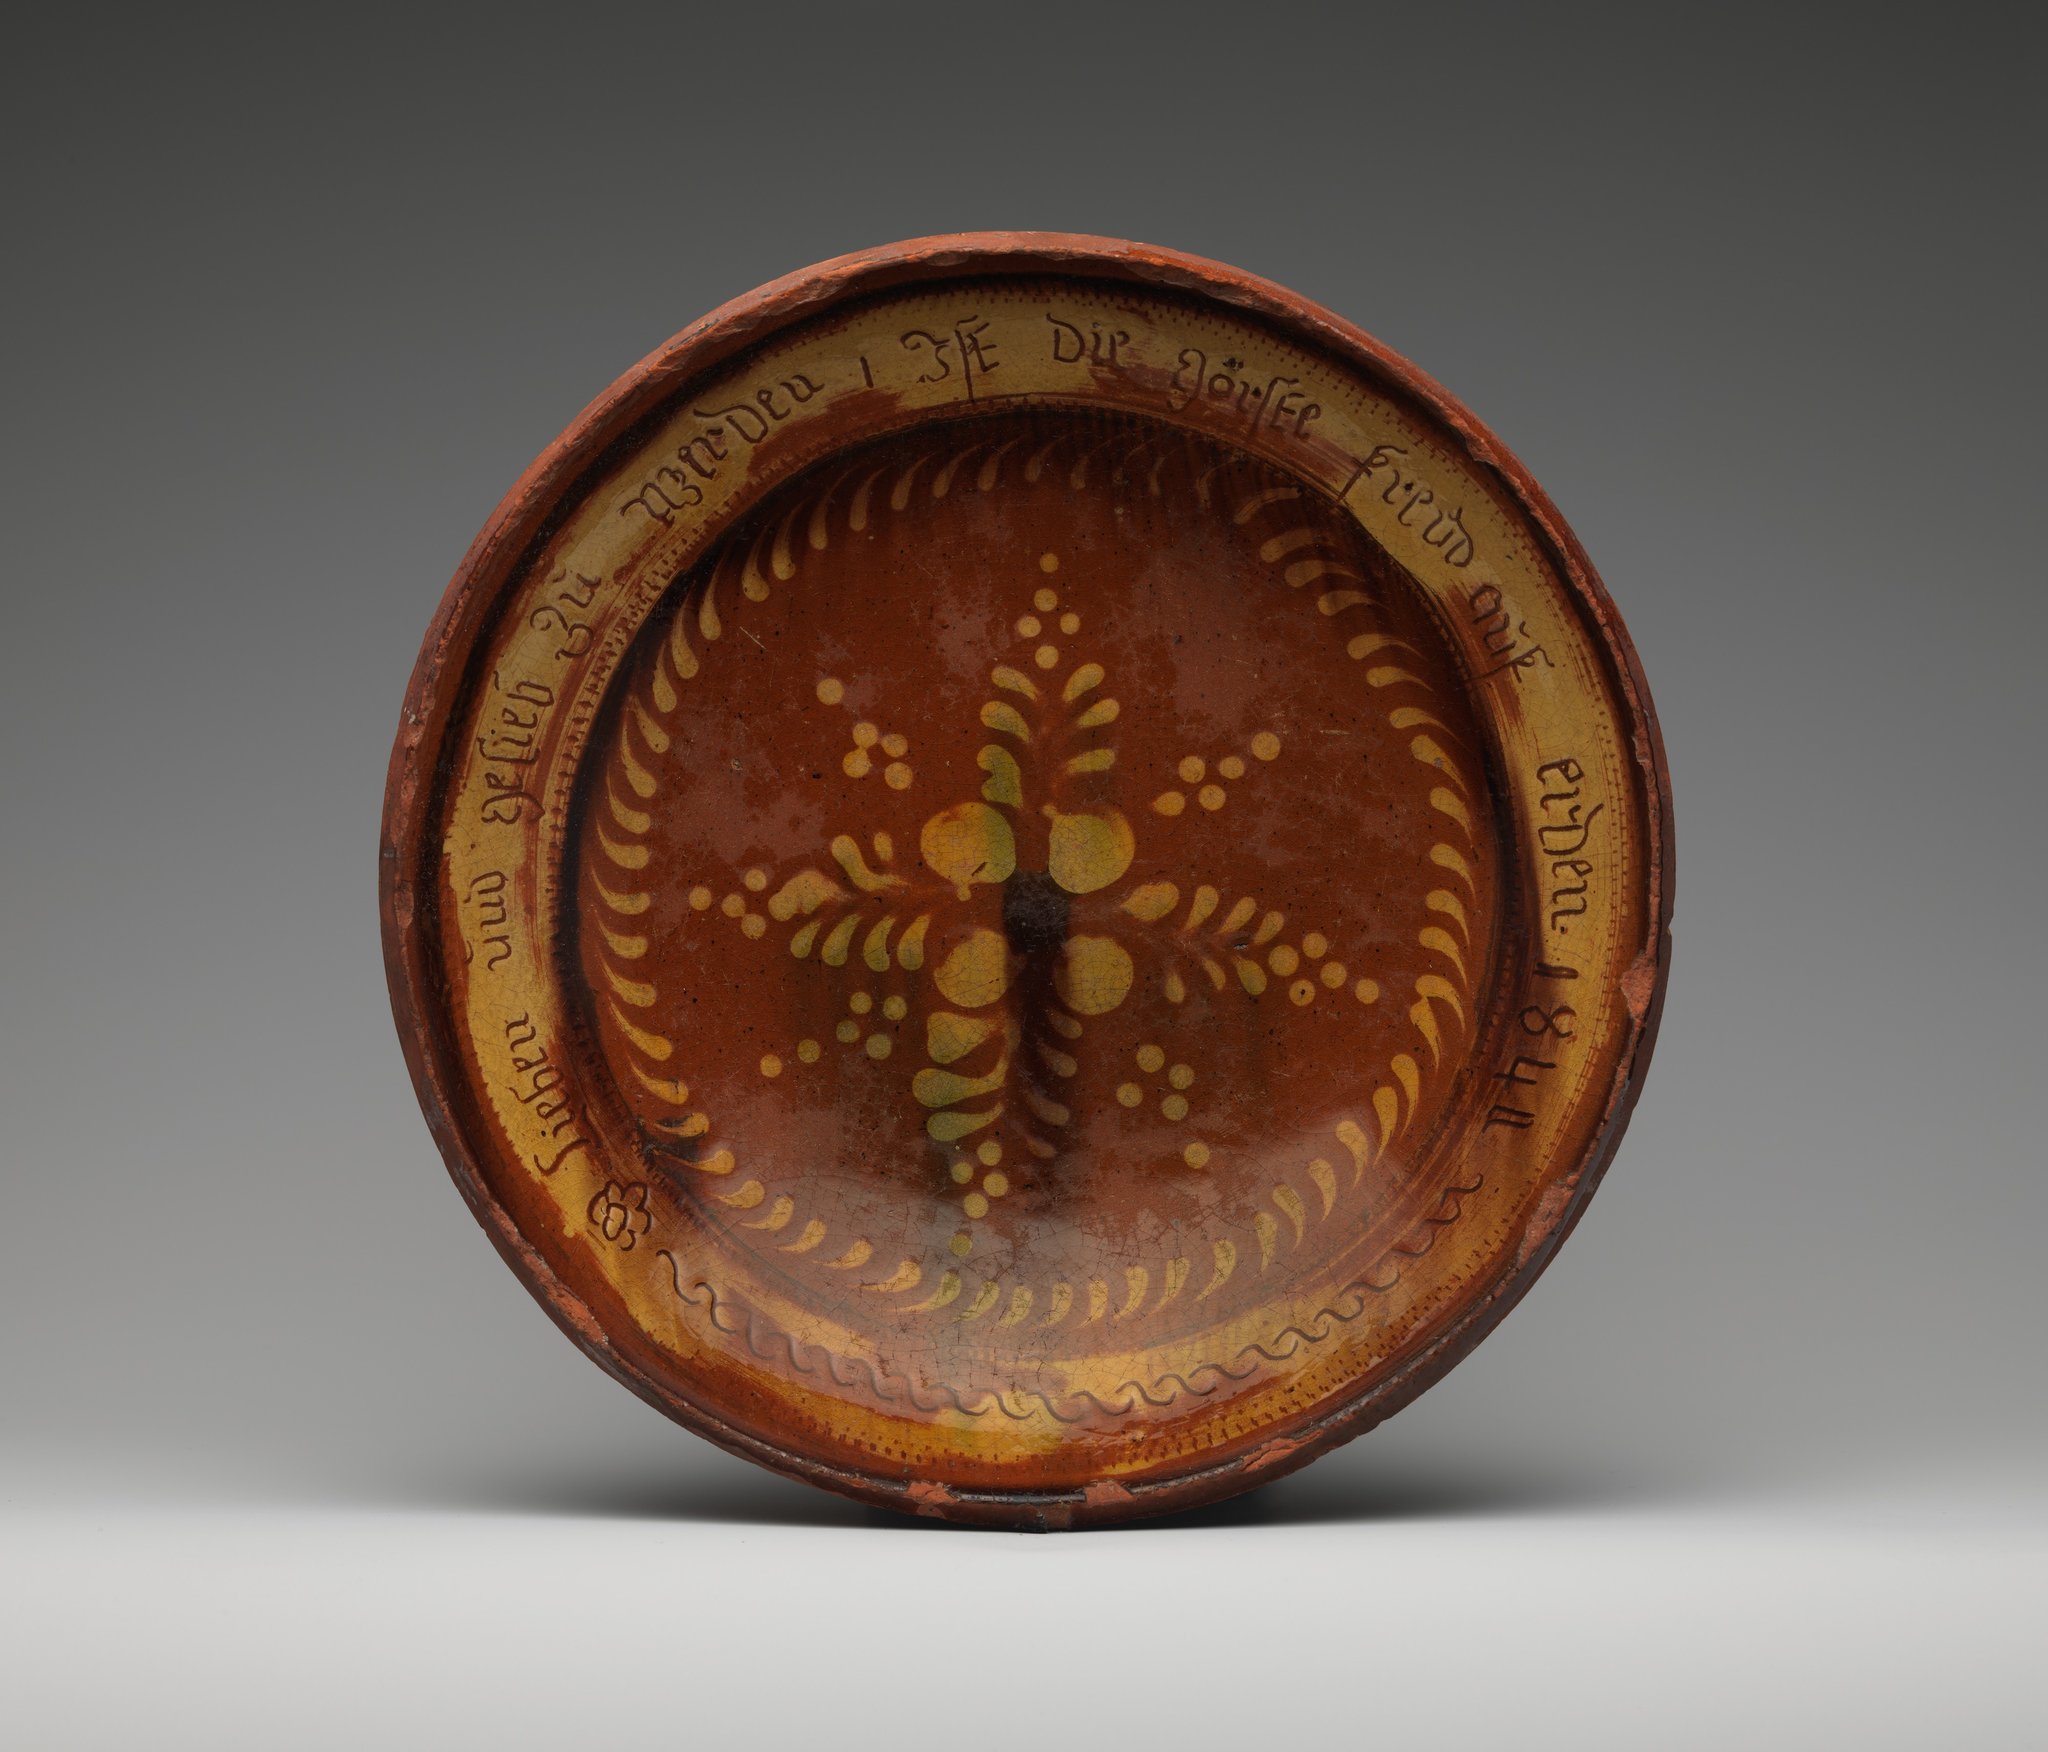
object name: plate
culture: american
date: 1841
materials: earthenware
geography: united states